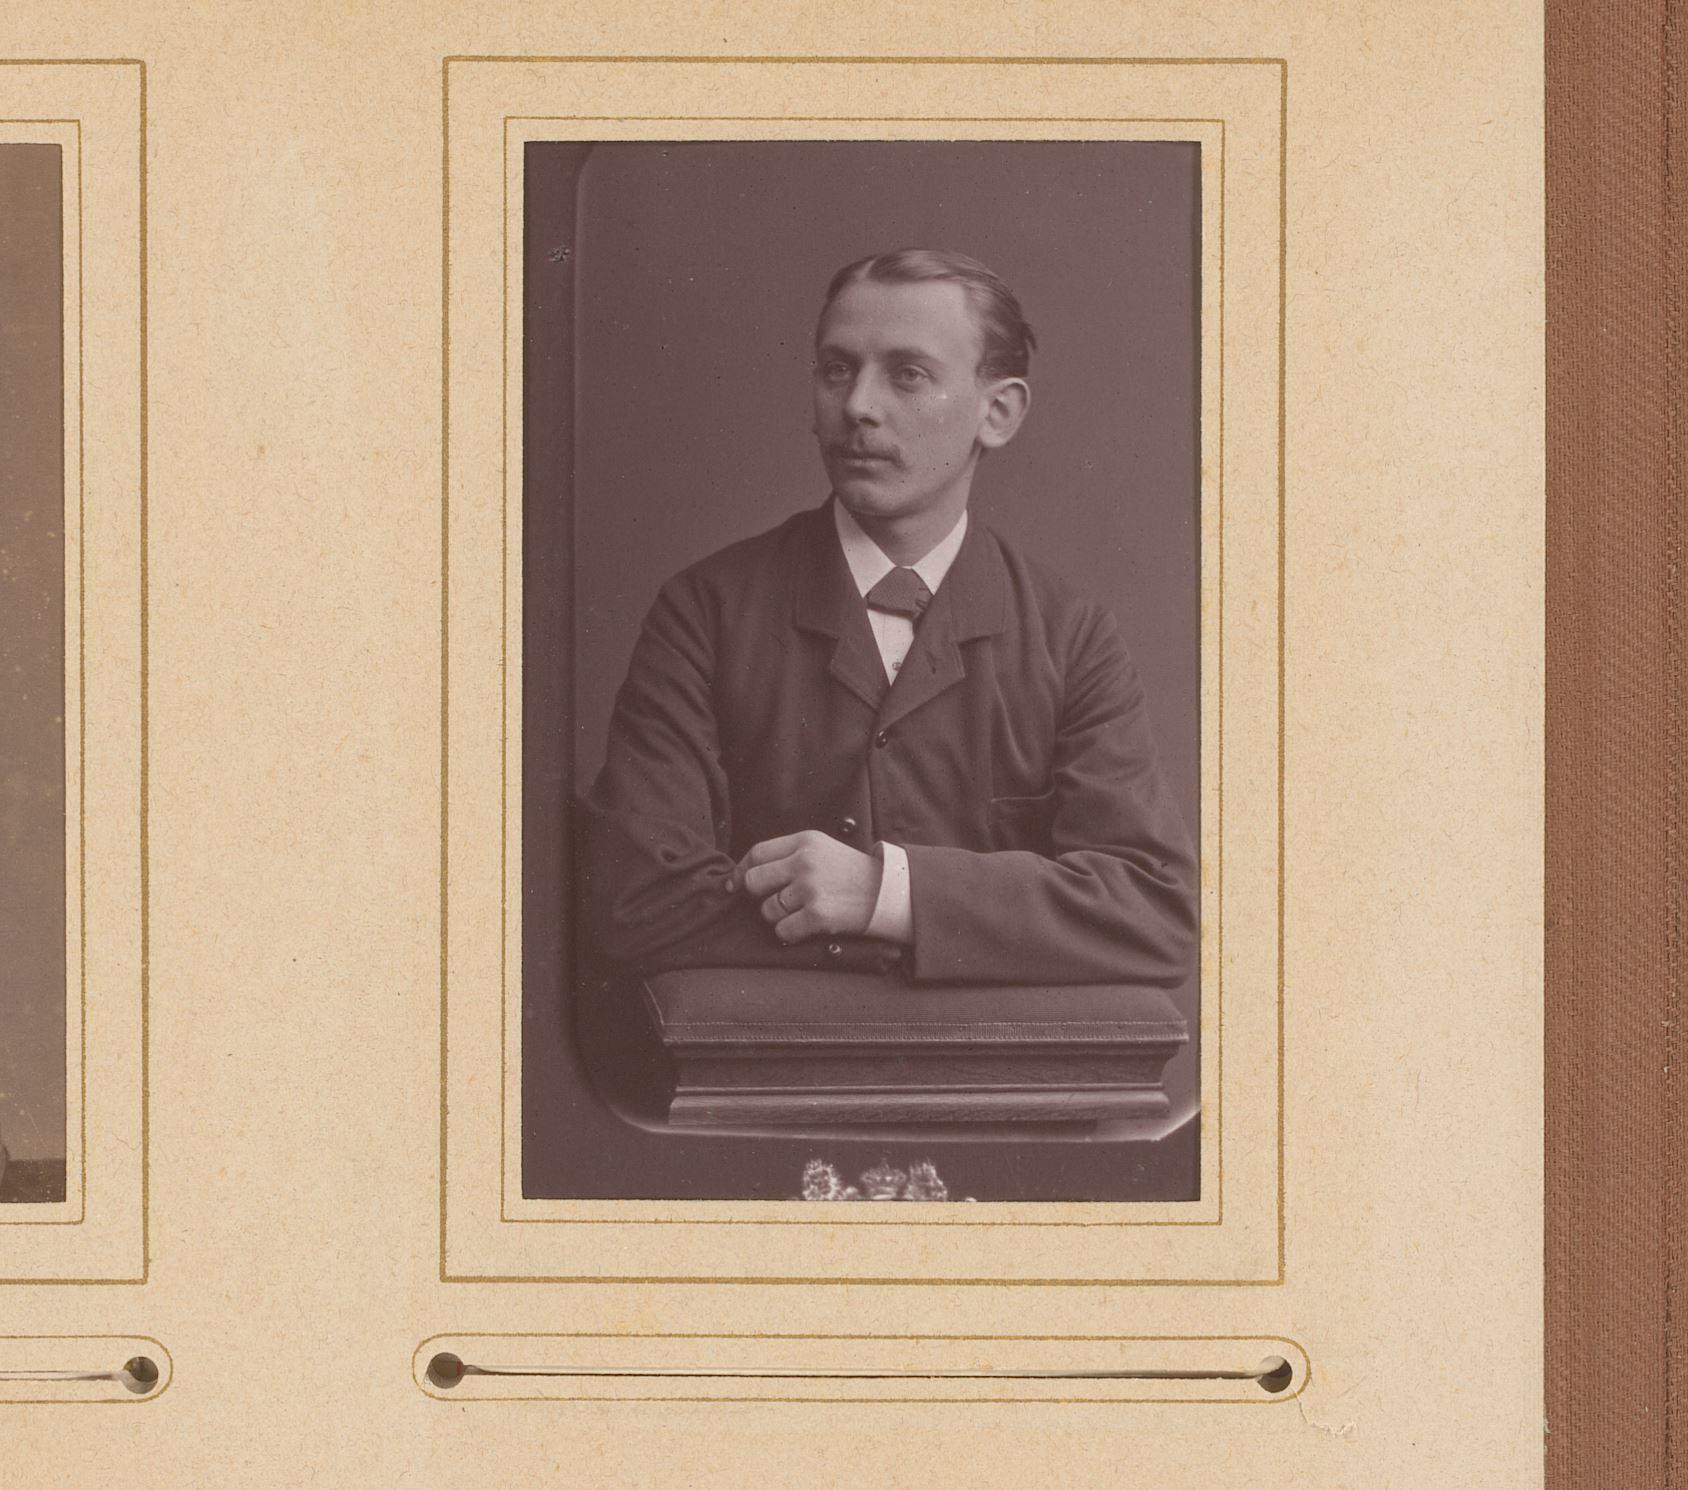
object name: album leaf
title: Portret van een man met snor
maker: albert greiner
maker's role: fotograaf, fotostudio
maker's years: 1833-1890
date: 1880-1887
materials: cardboard, celluloid, photographic support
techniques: carbon print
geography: amsterdam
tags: moustache, historical persons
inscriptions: inscription: ‘A. Greinter/ Photograaf/ van H H. M M. den koning en/ de koningin der Nederlanden/ Niewendyk L 89/ Amsterdam’